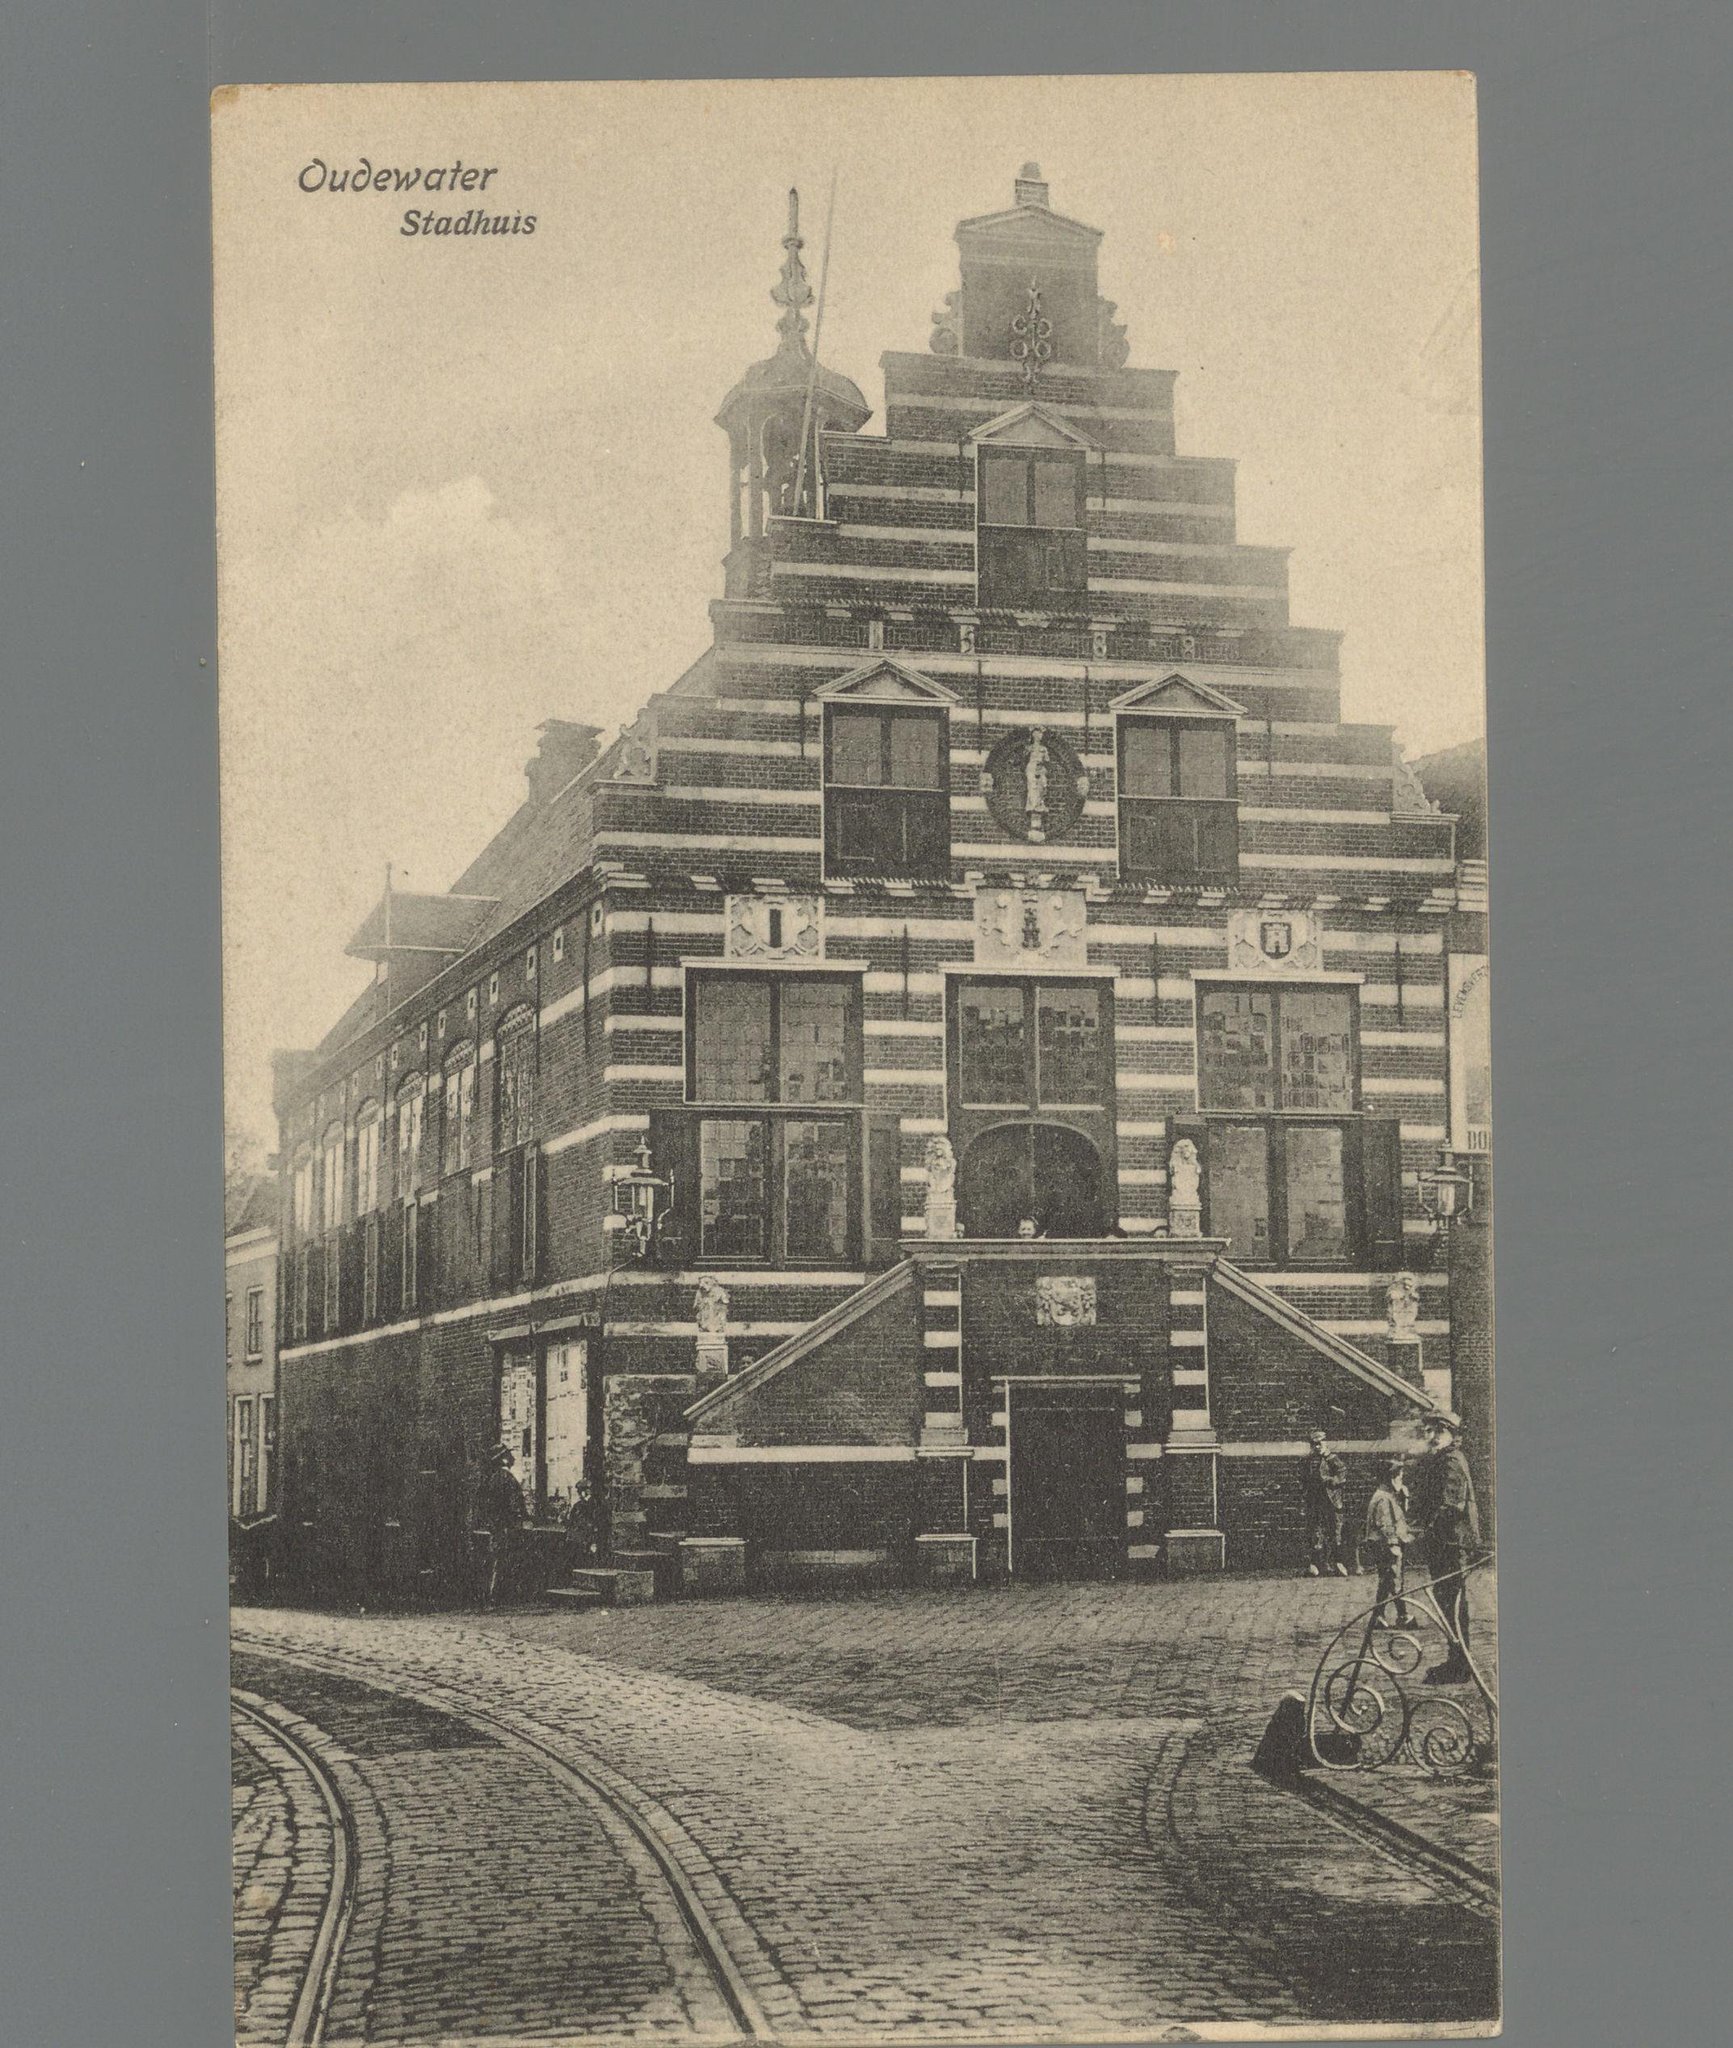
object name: photomechanical print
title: Oudewater. Stadhuis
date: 1909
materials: cardboard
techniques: photograph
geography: oudewater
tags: townhall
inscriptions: date